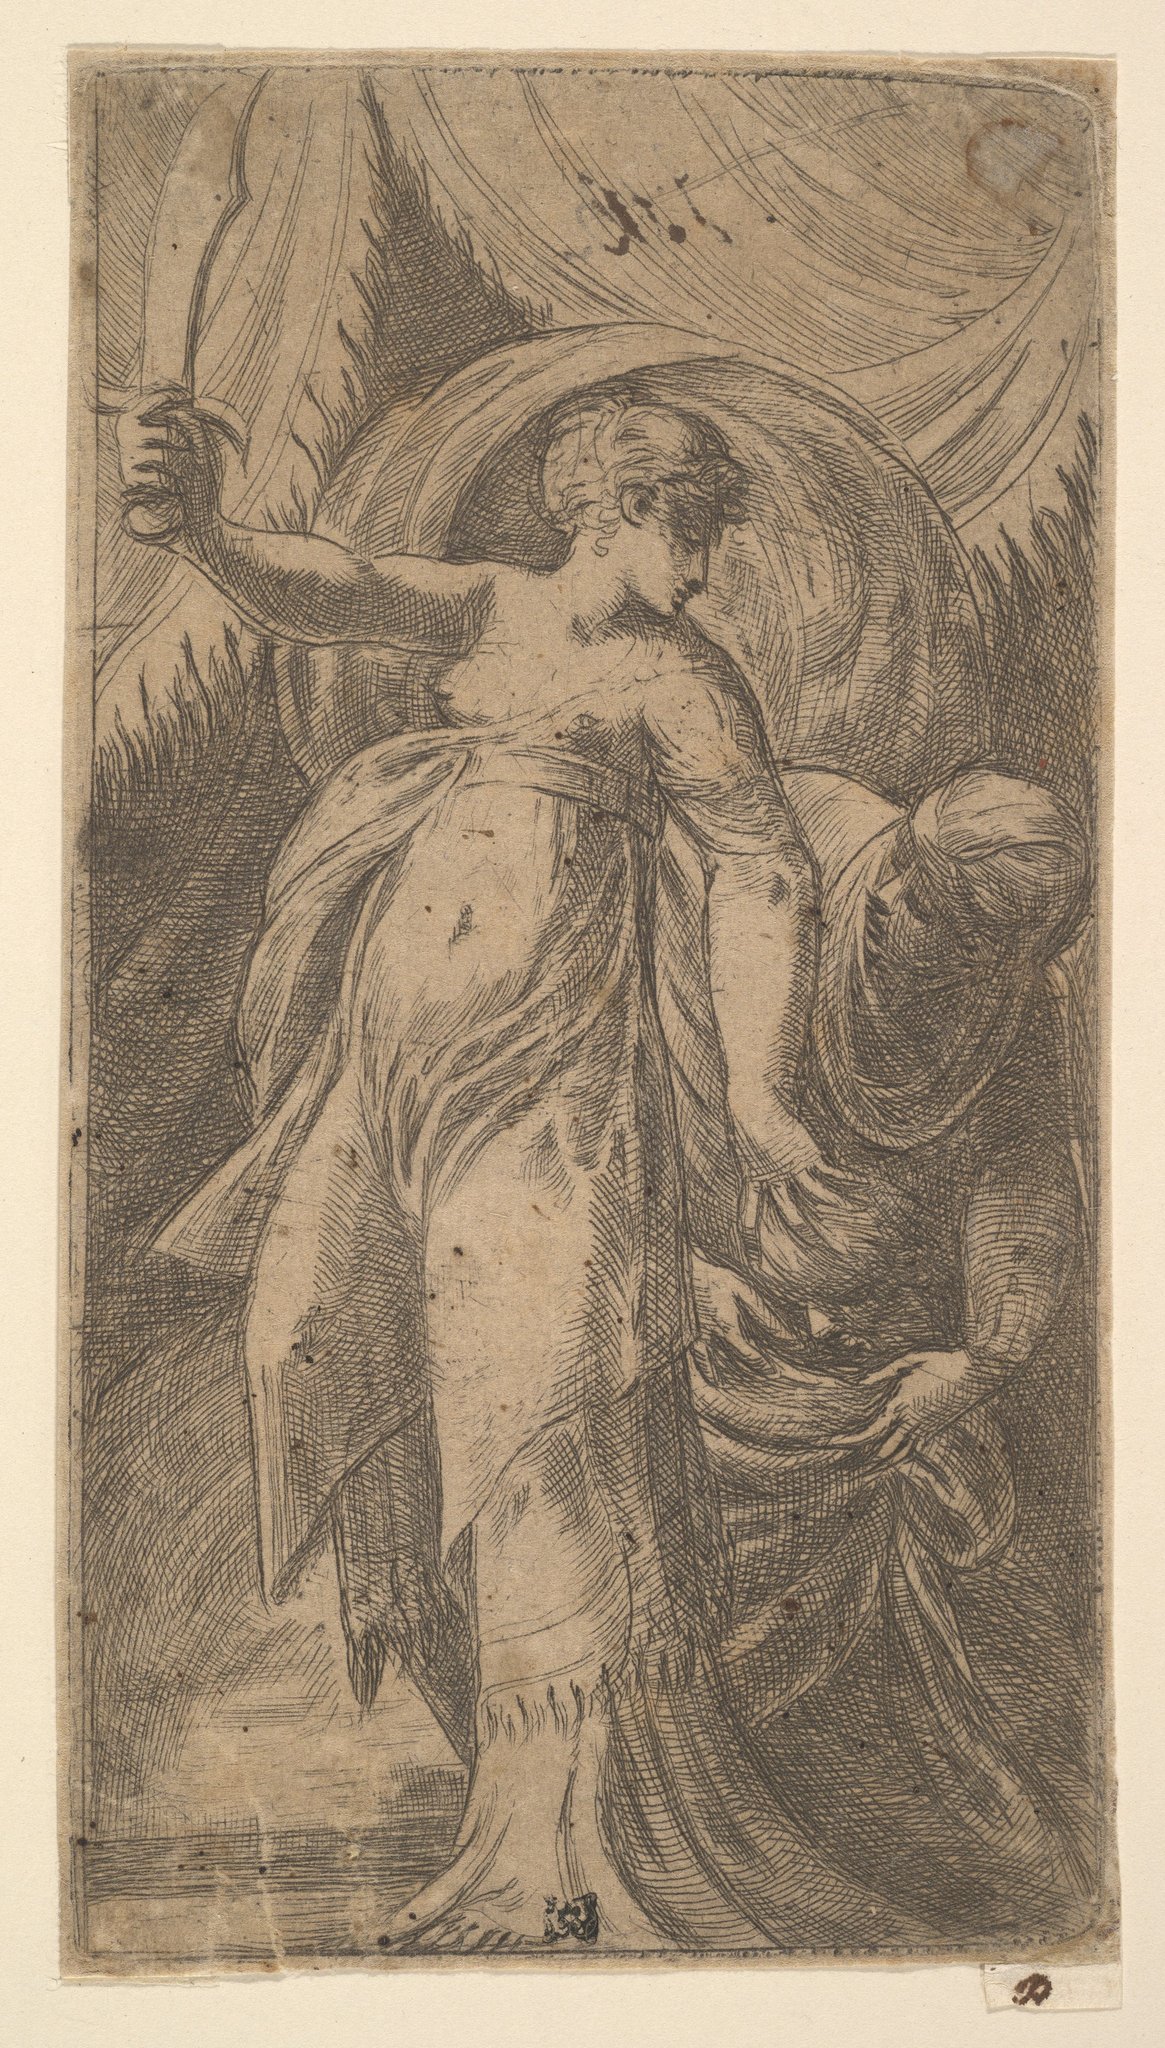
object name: print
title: Judith with her sword raised in her right hand and placing the head of Holofernes in the sack with her left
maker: andrea schiavone (andrea meldola)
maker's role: artist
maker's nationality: italian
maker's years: 1510-1563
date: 1540-1545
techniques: etching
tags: swords,holofernes,judith